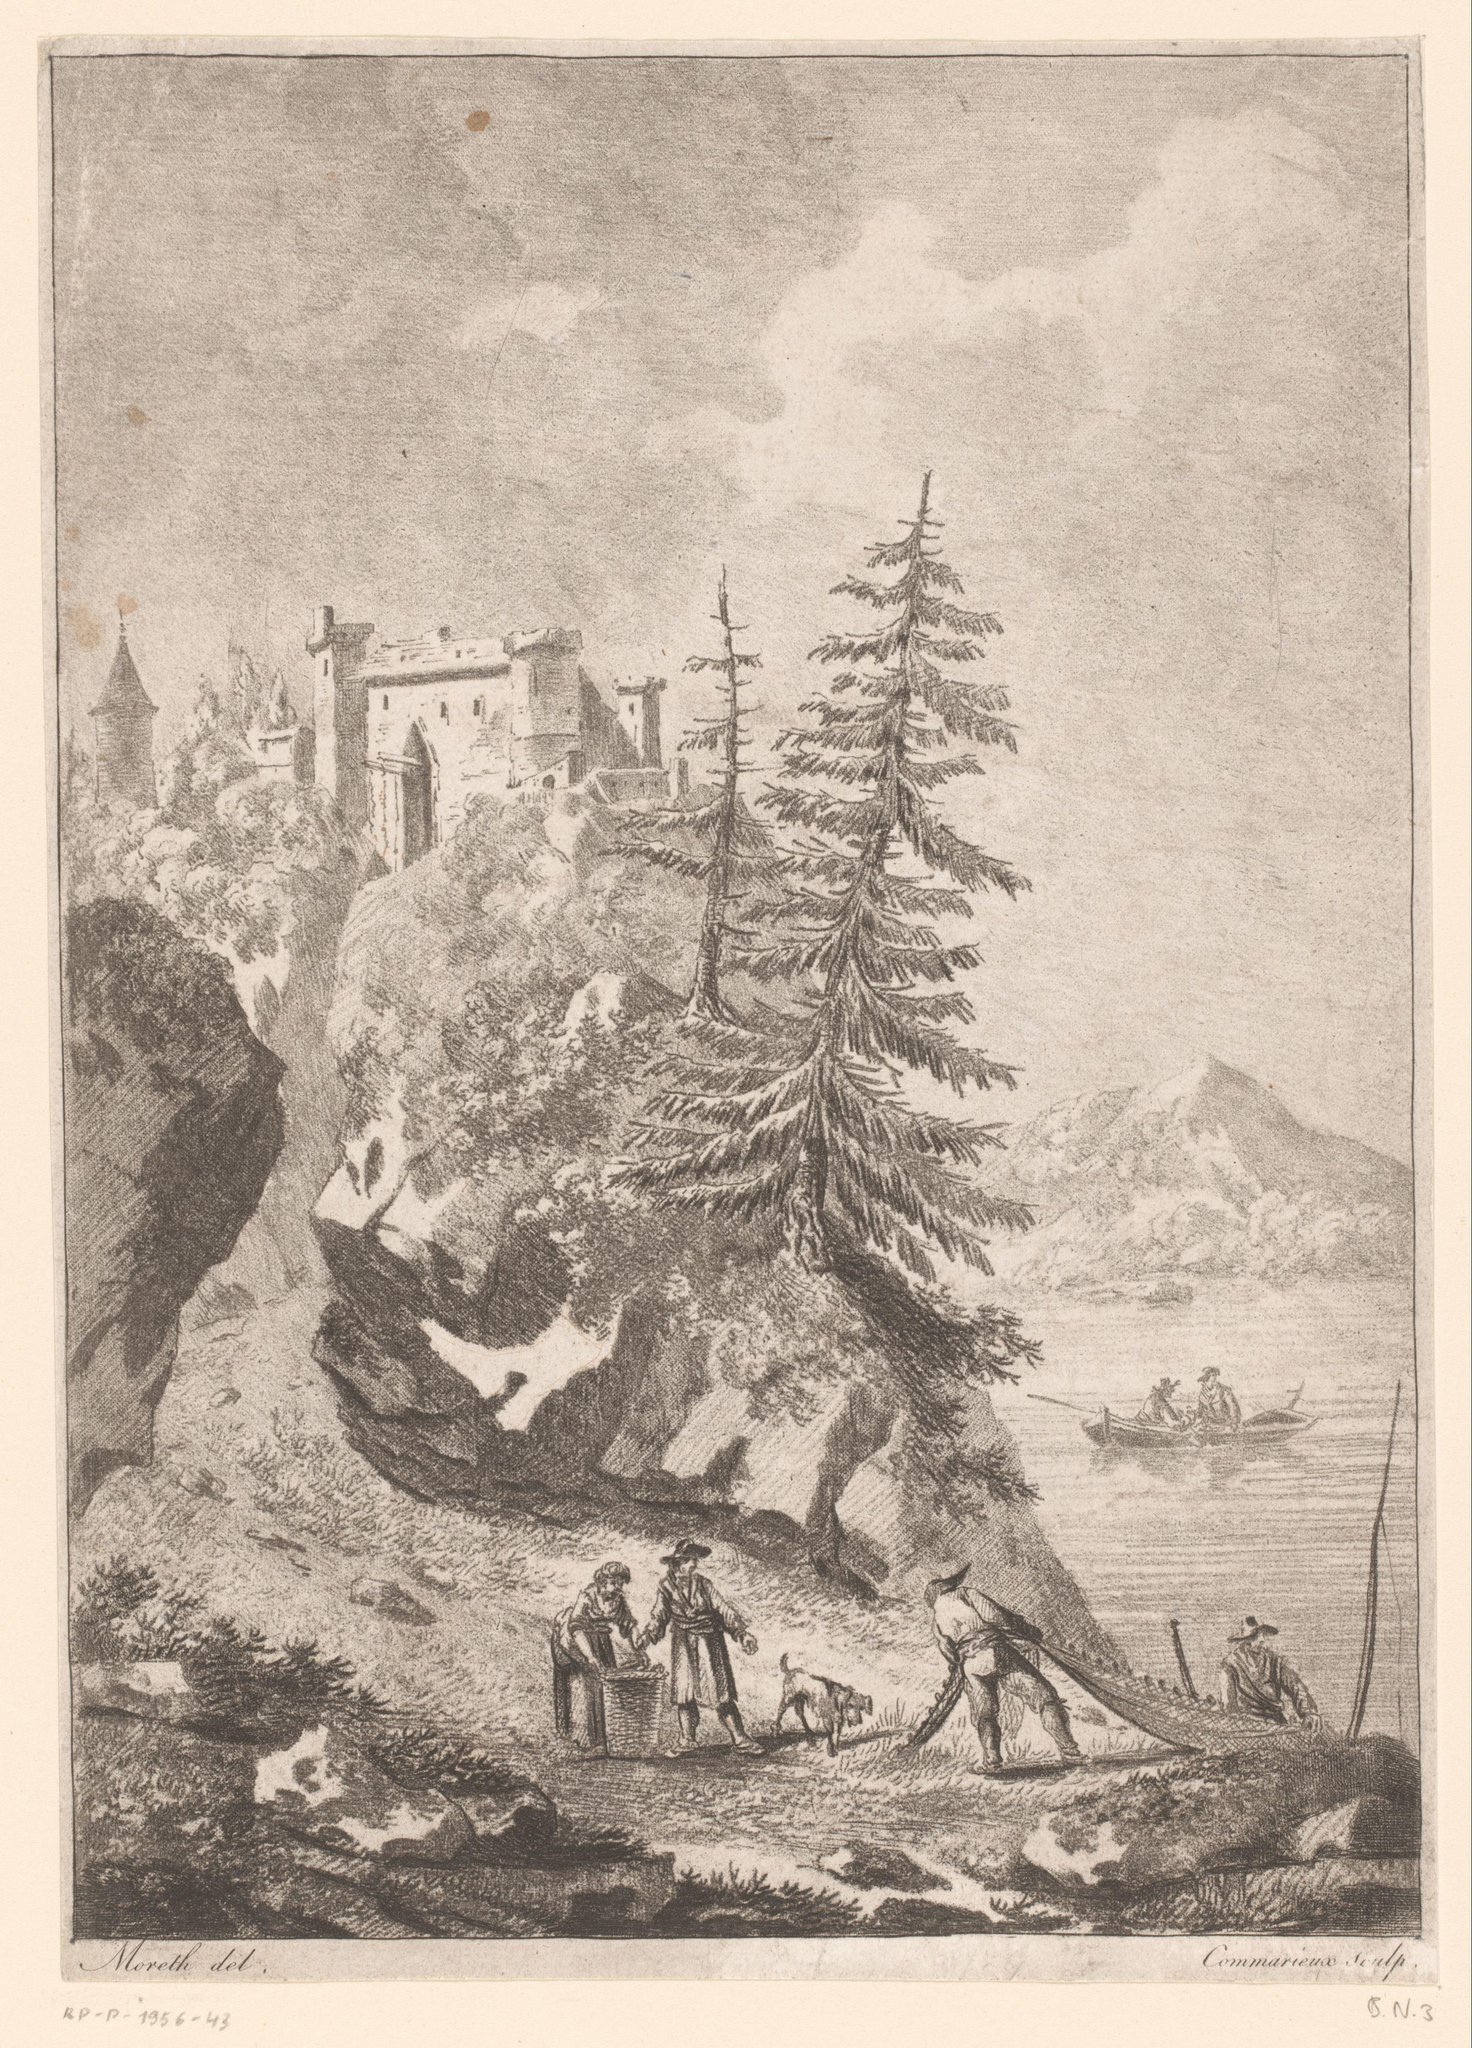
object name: print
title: Principes de paysages gravés à l'ignistil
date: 1810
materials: paper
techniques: printmaking, roulette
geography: france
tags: lake, landscape with tower or castle, fisherman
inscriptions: collector's mark: Lugt 2228, collector's mark: Lugt 2760